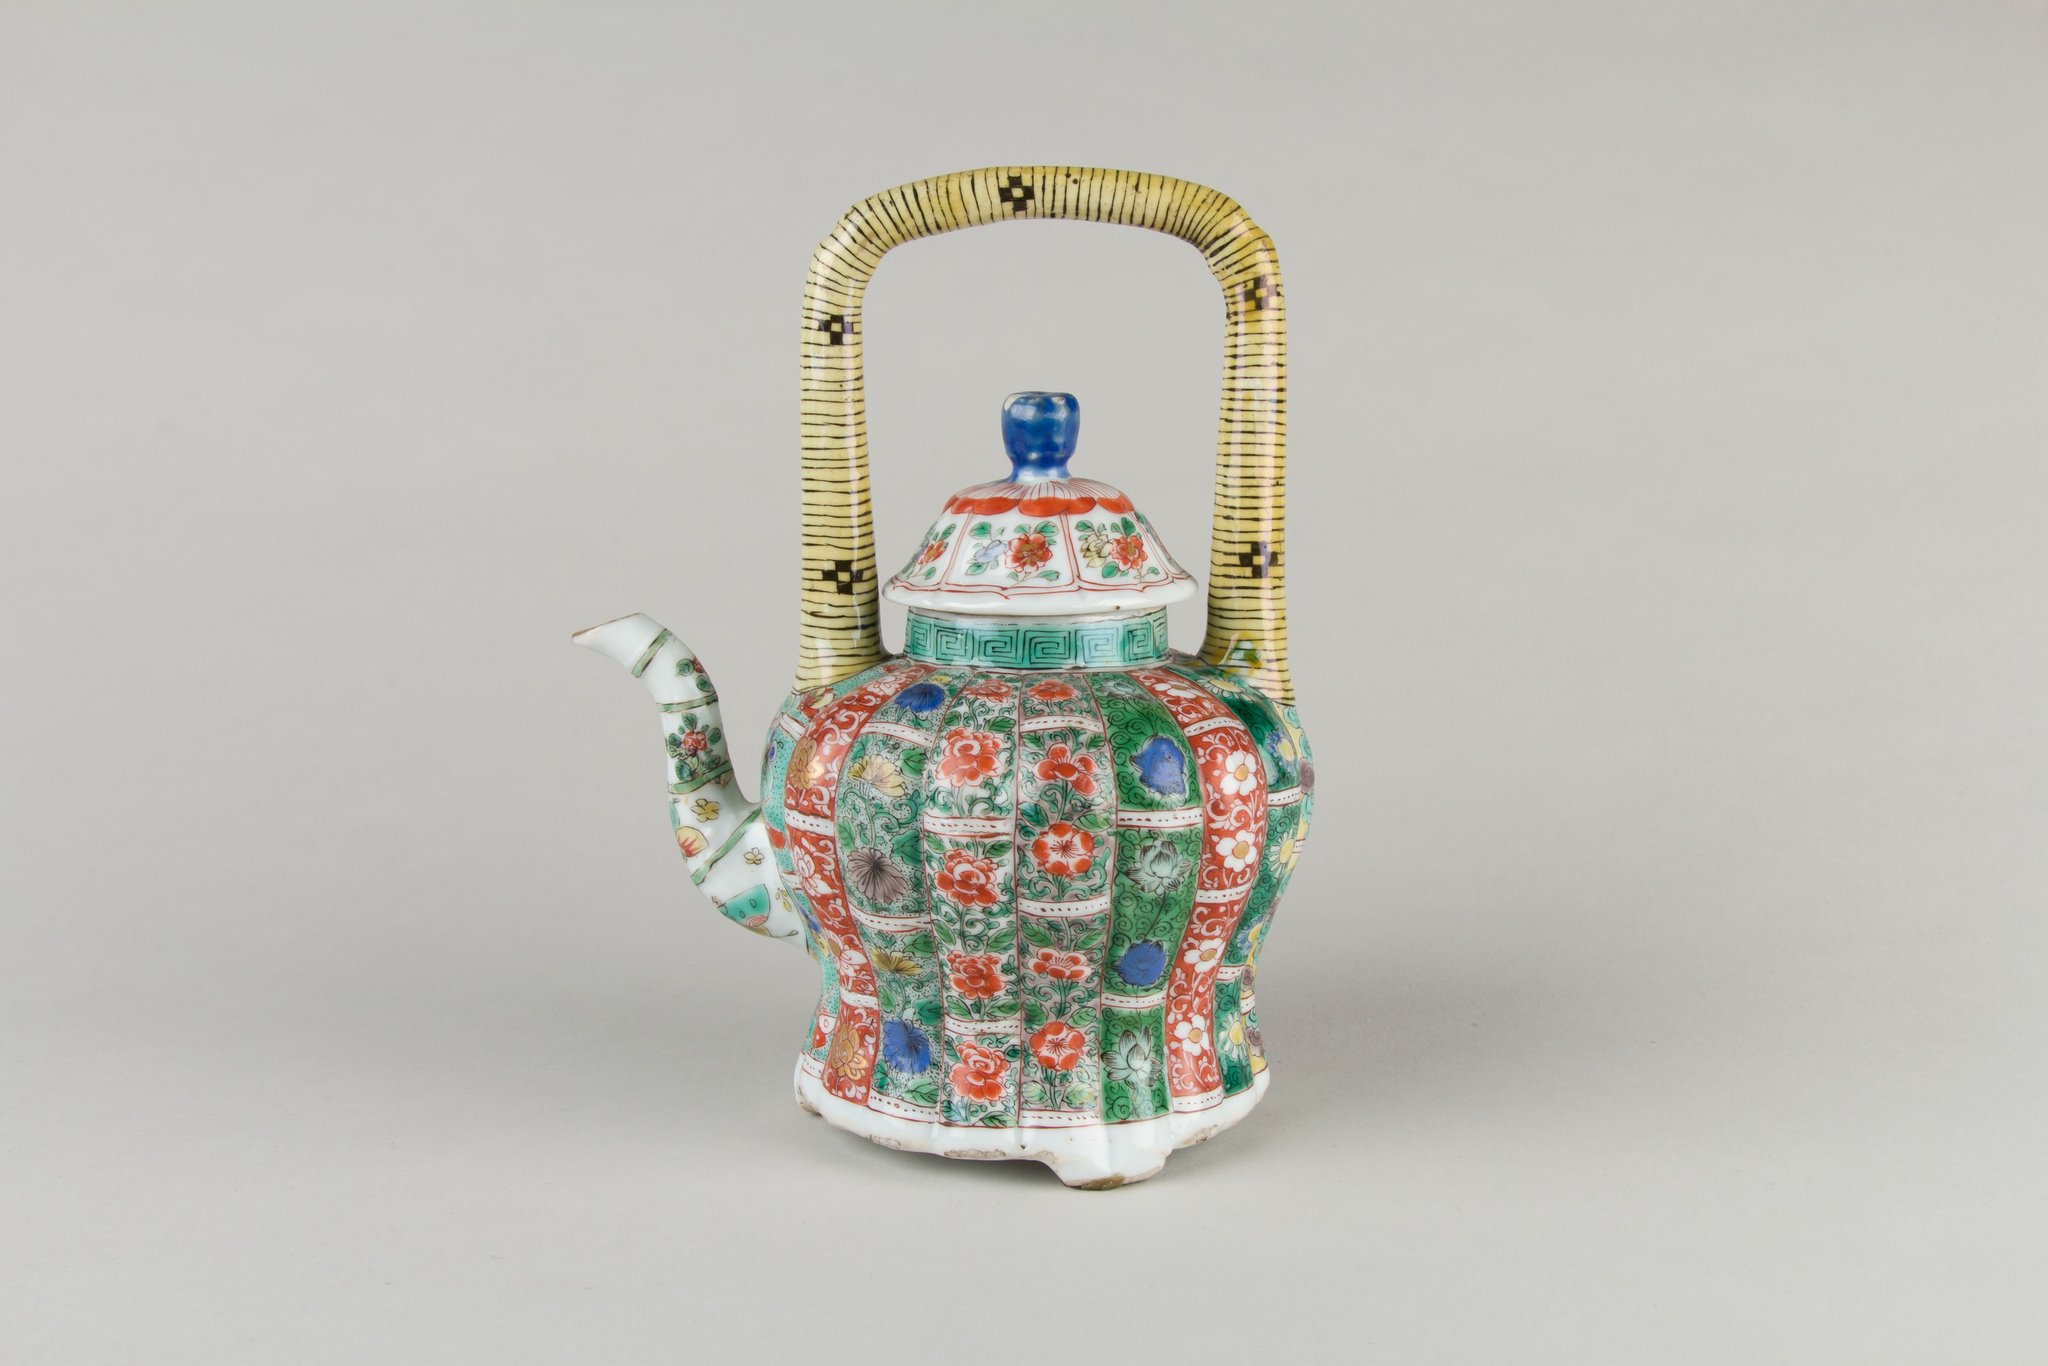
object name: teapot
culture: chinese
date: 1644-1911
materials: porcelain